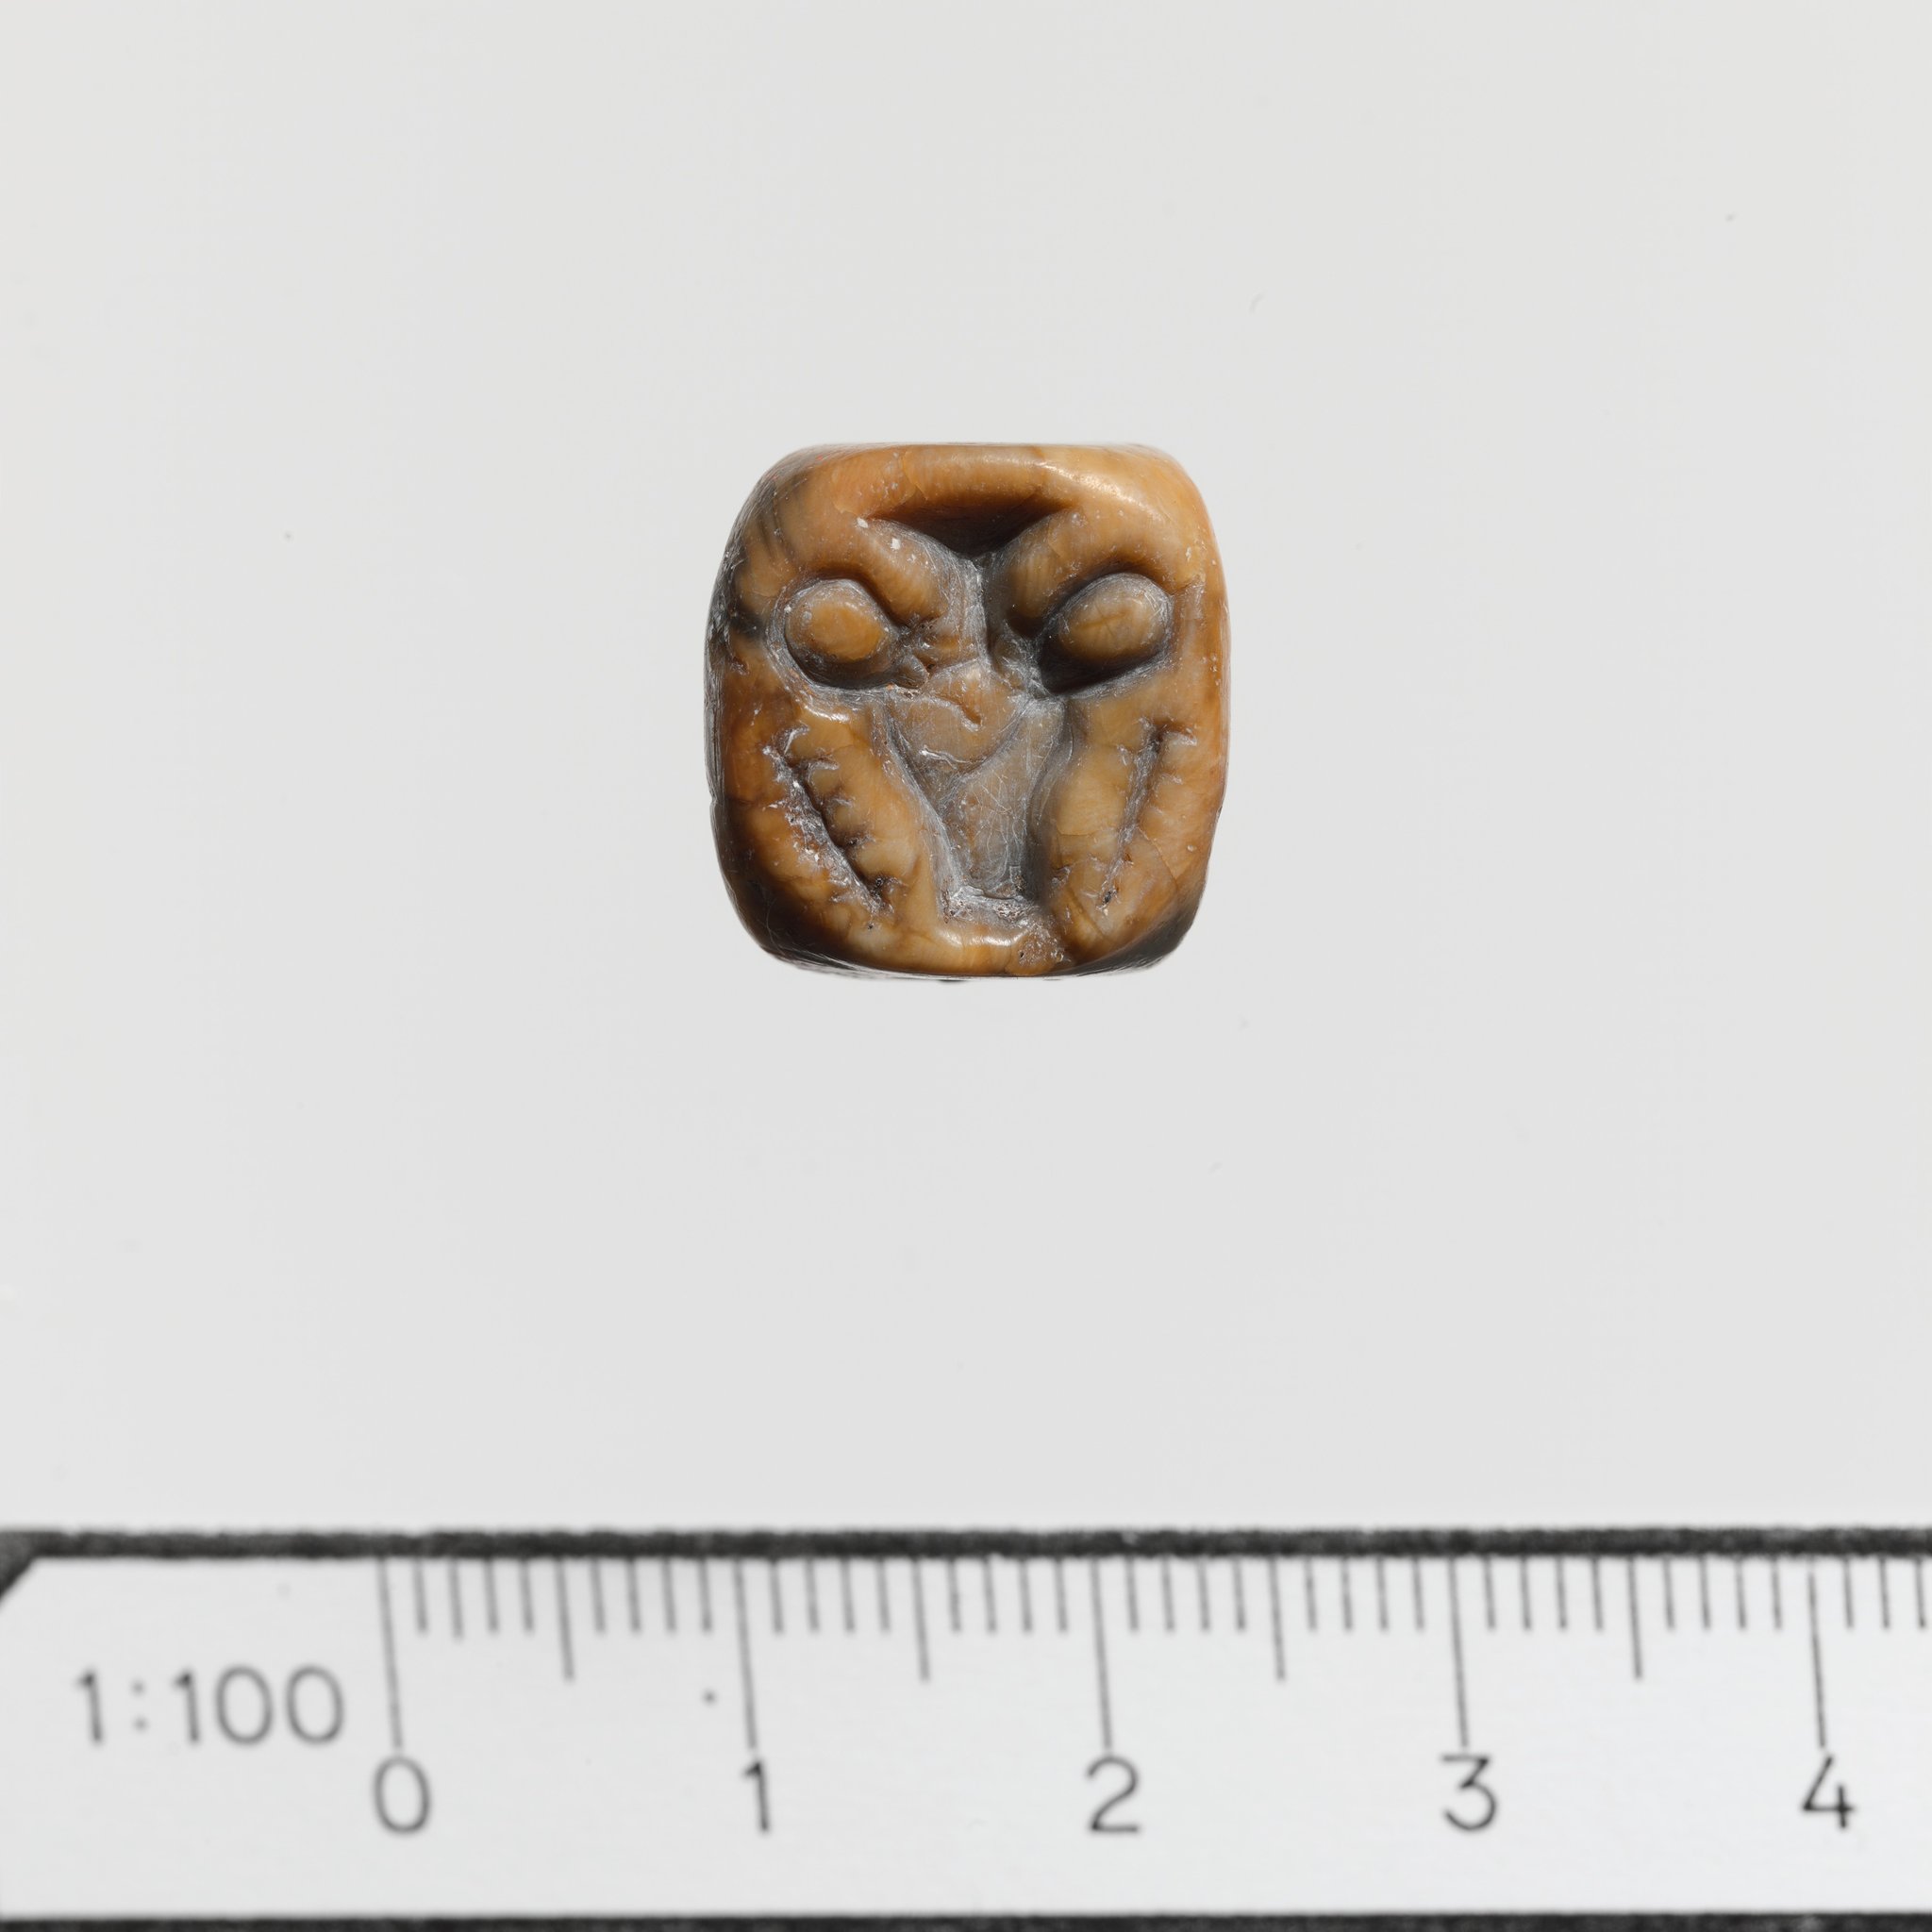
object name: prism, triangular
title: Steatite triangular prism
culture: minoan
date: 2200-1750 BCE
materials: stone